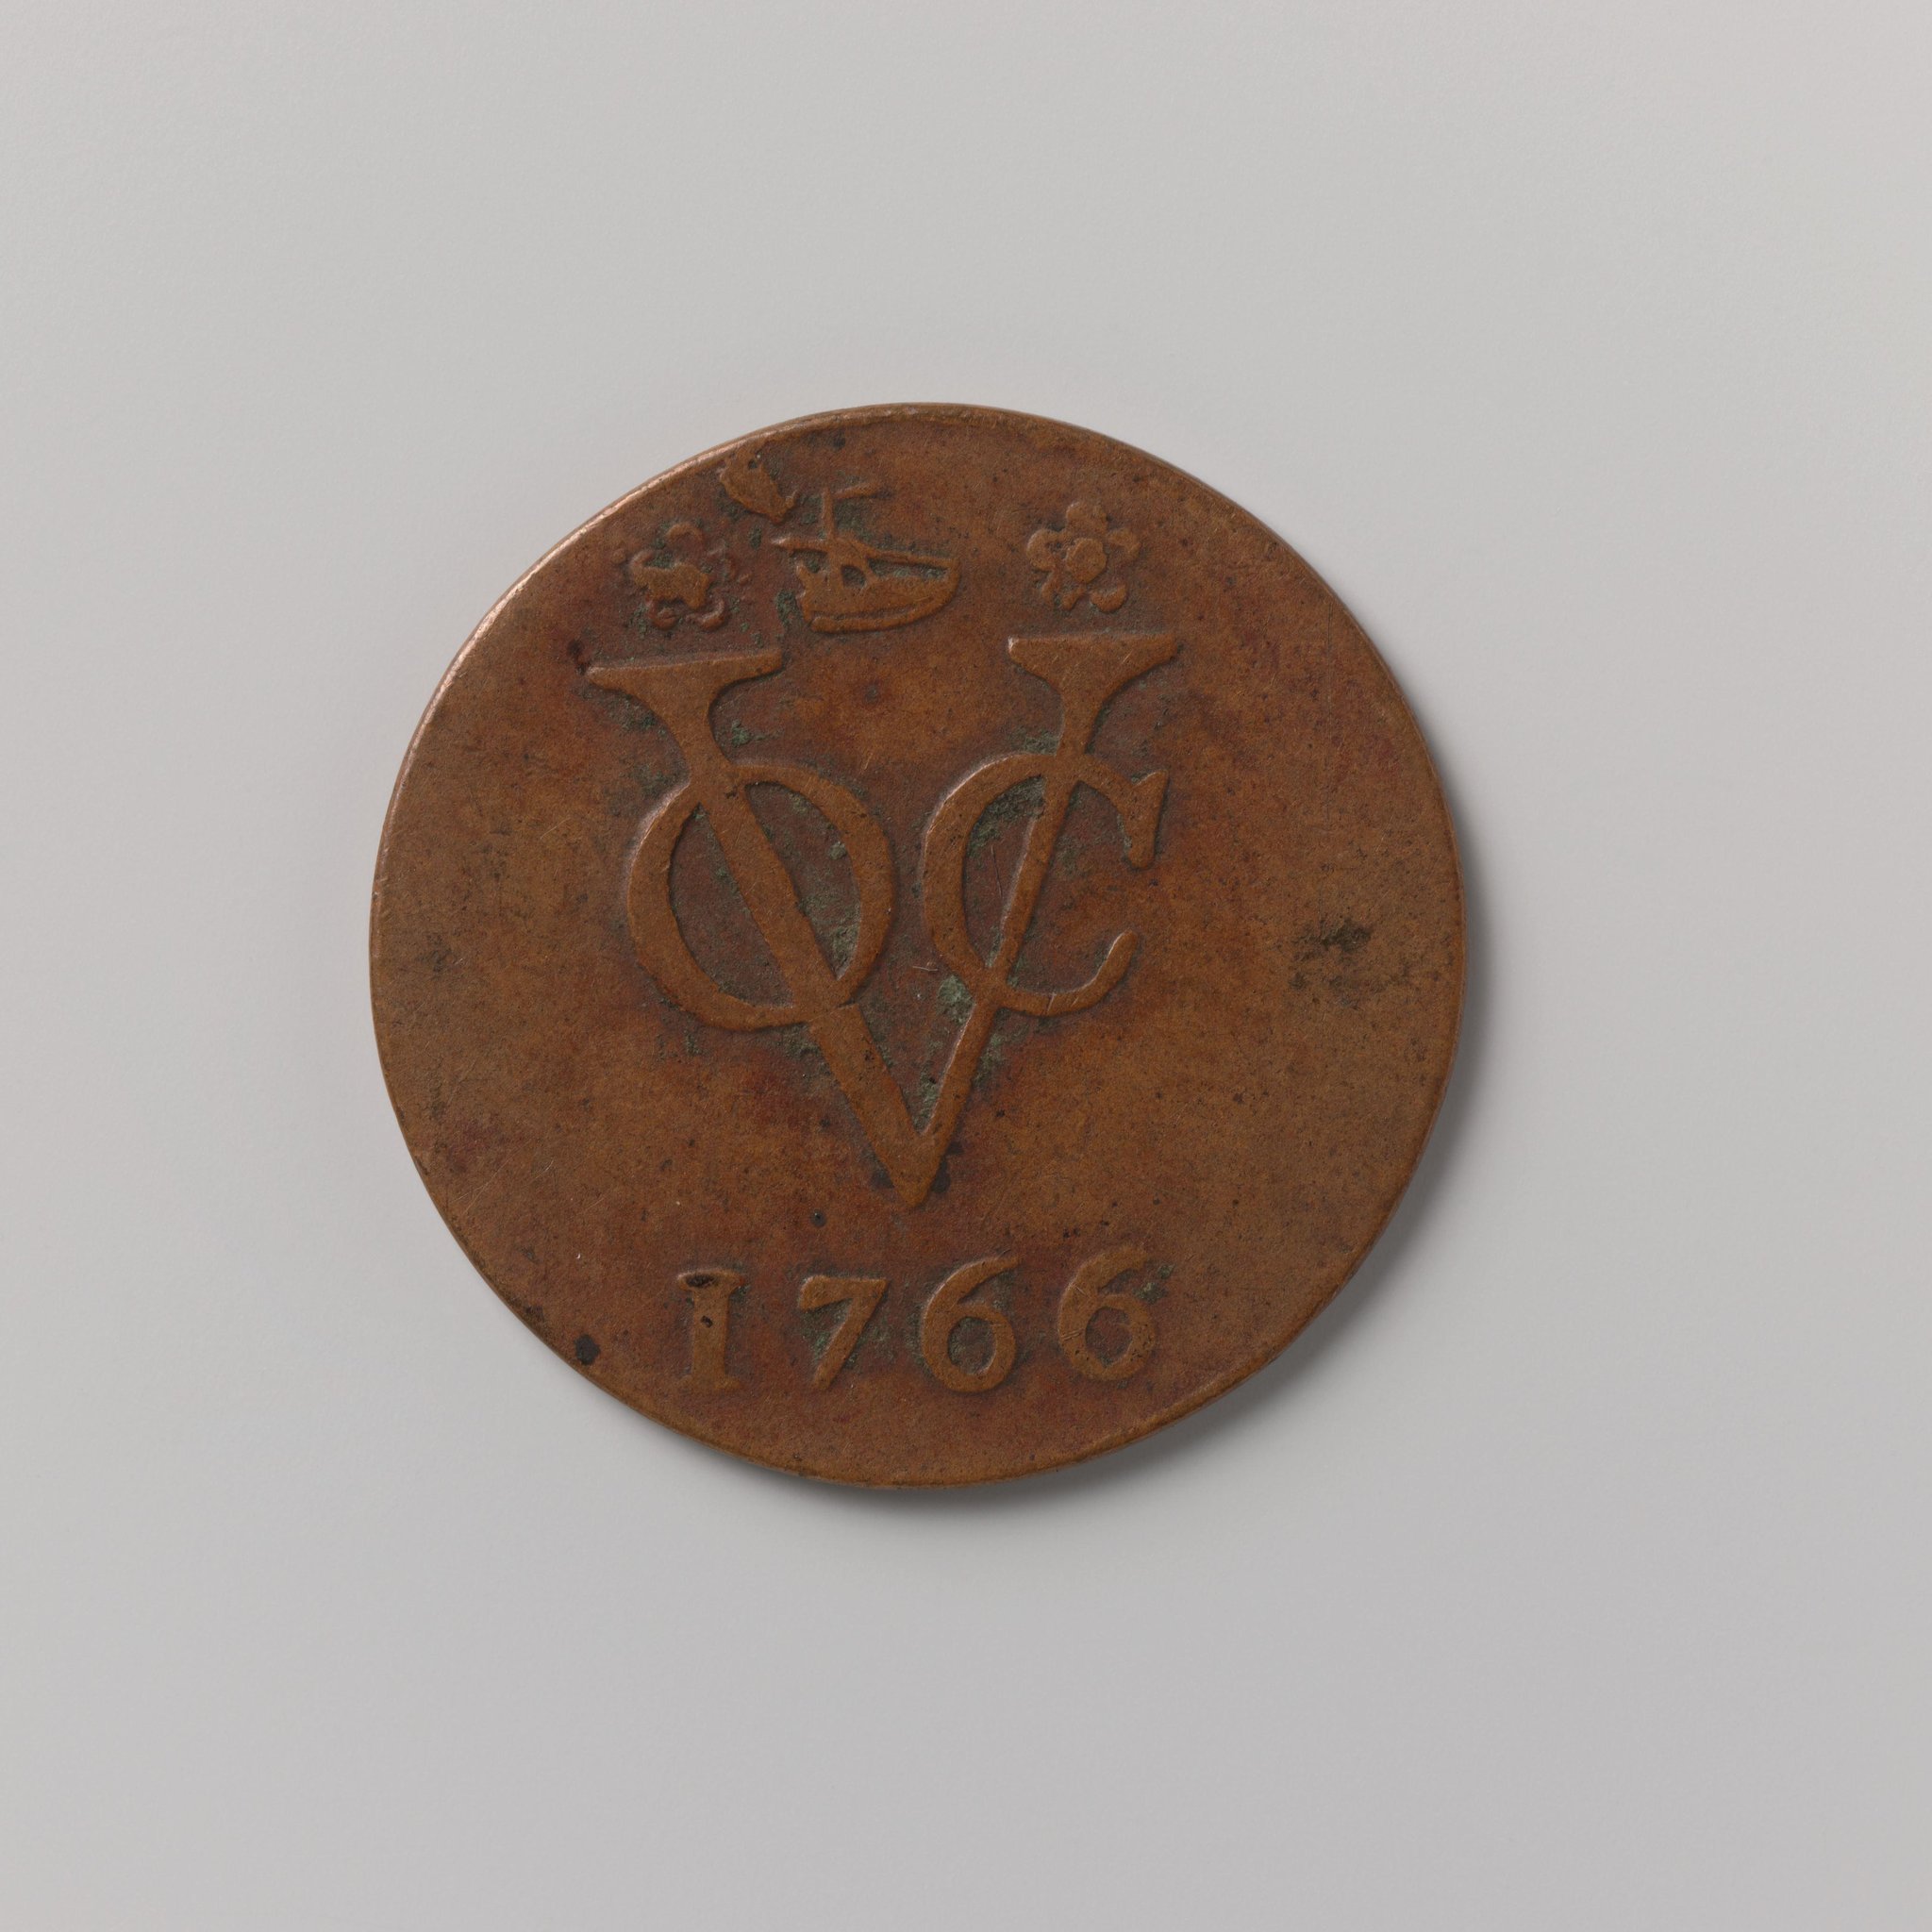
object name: coin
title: Duit van de VOC uit Westfriesland,1766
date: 1766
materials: copper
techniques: striking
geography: enkhuizen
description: Koperen munt. Voorzijde: gekroond wapenschild van Westfriesland. Keerzijde: monogram van de VOC, waarboven muntmeesterteken en waaronder jaartal. Gladde rand.